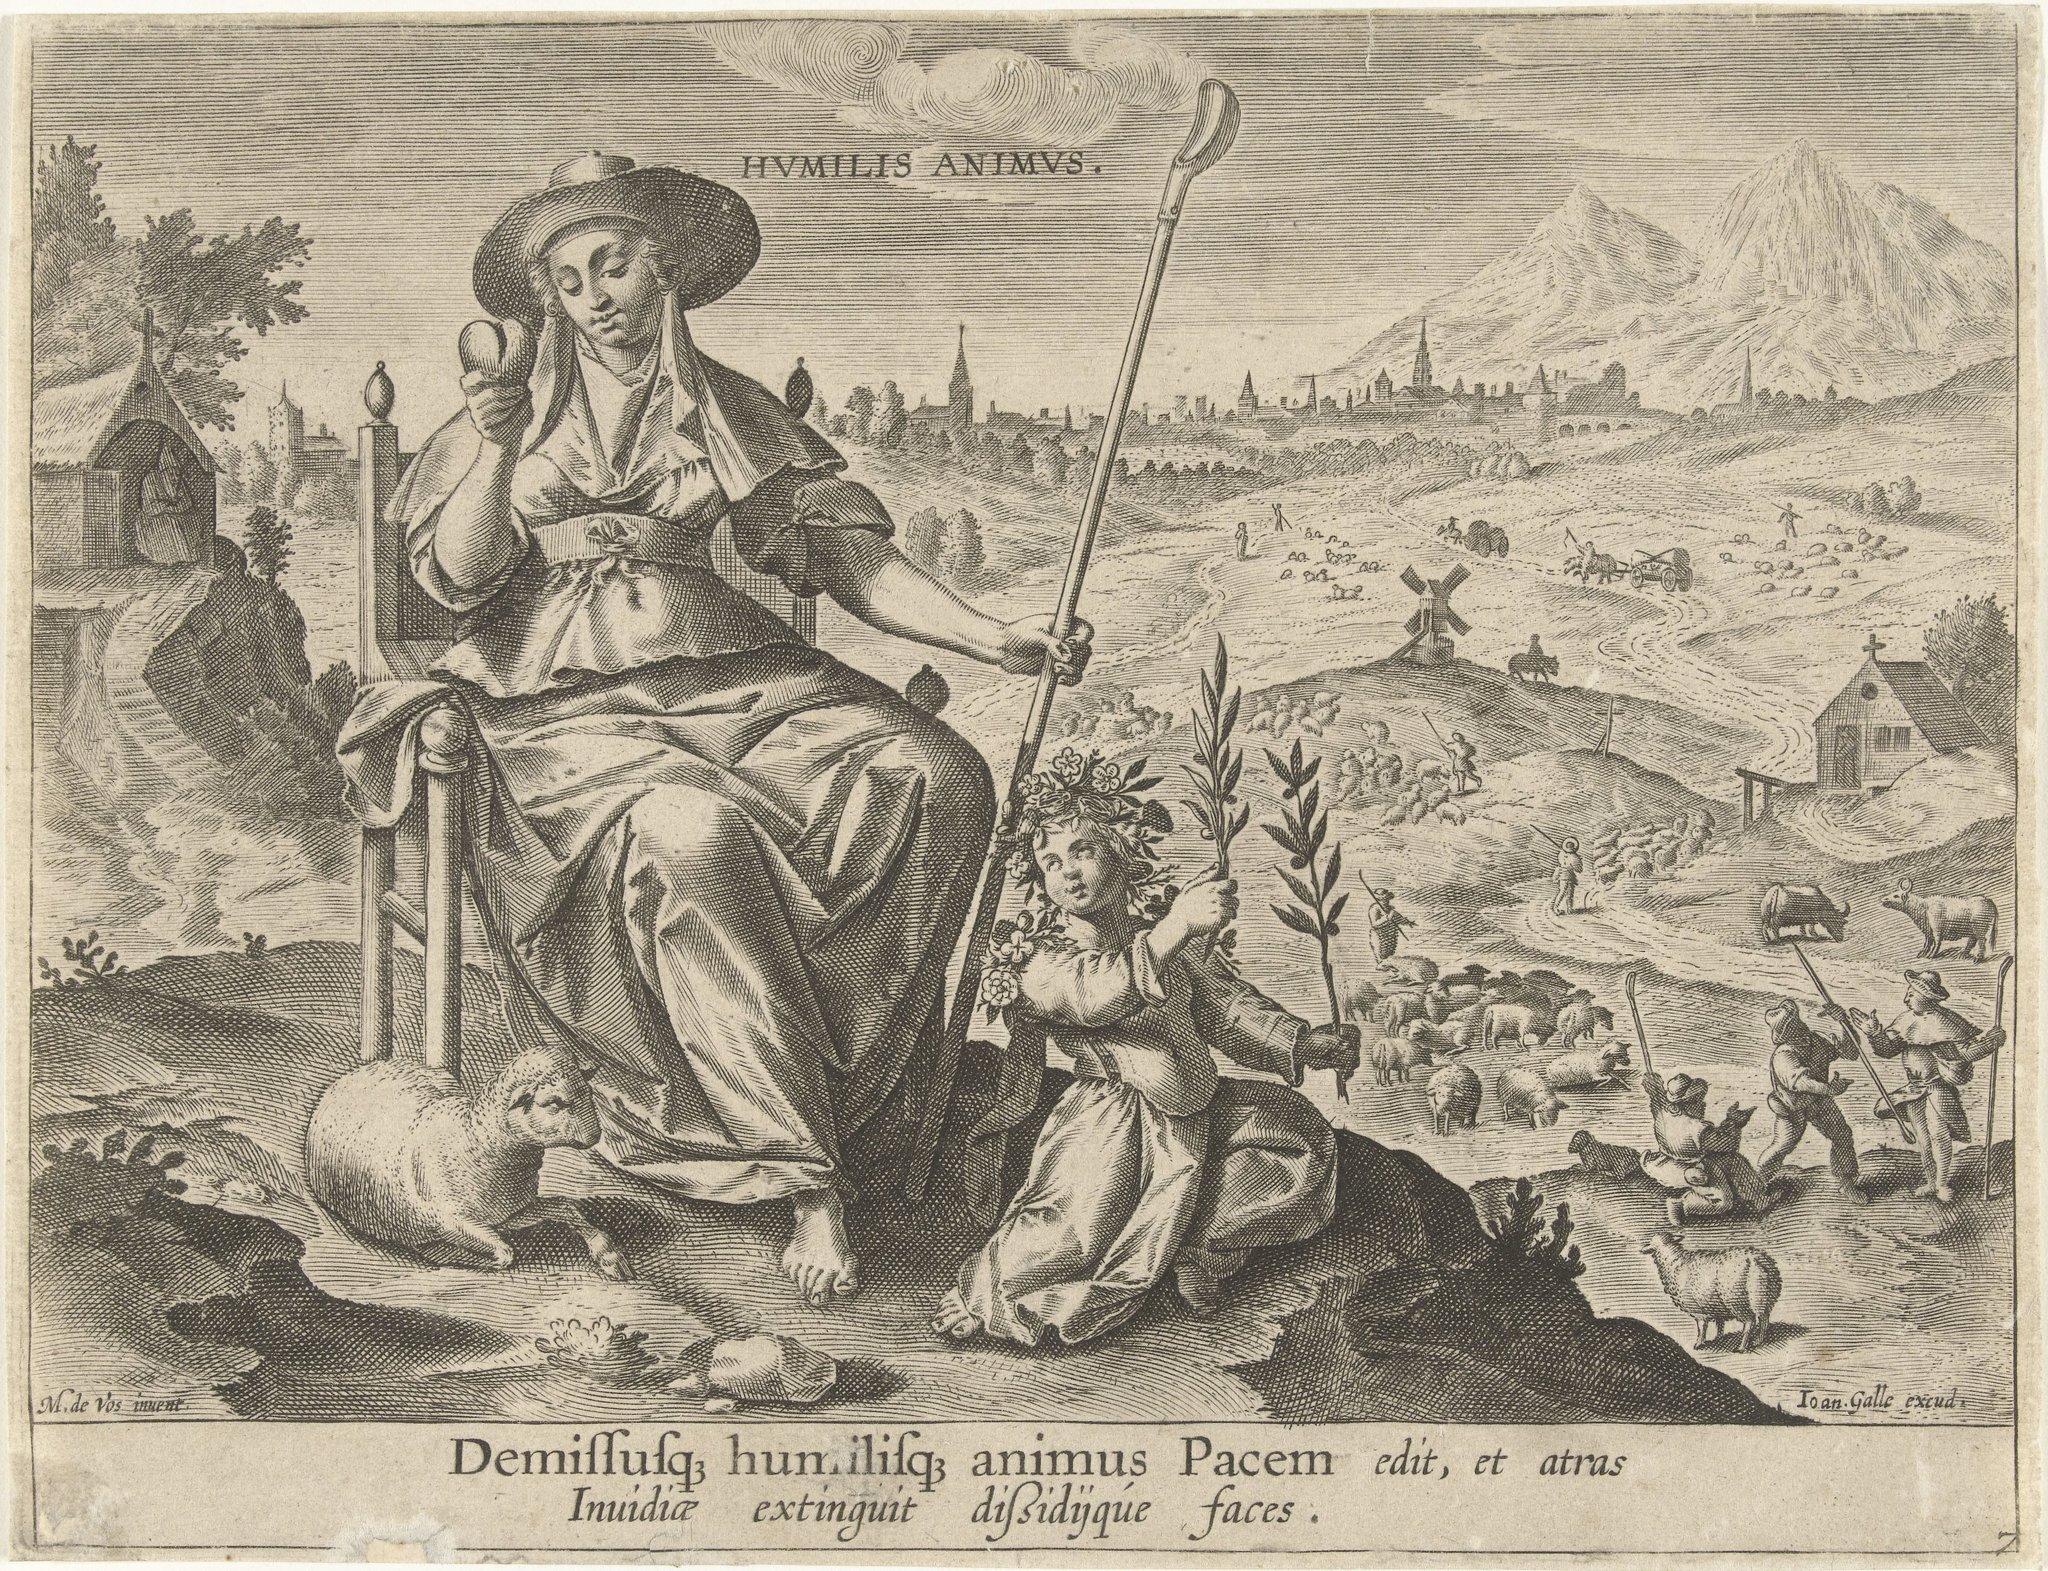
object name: print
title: Circvlvs Vicissitvdinis Rervm Hvmanarvm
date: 1610-1676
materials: paper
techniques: engraving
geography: antwerp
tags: symbols, allegories of peace, 'pax'; 'pace' (ripa), vicissitudes of life, pastorals, arcadian scenes, humility; 'humiltà' (ripa)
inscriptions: collector's mark: Lugt 2228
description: De personificatie van Nederigheid (Humilis Animus) zit op een stoel, een herdersstaf en een gekliefd hart in haar handen. Aan haar voeten ligt een schaap en zit Vrede (Pax): een meisje met een olijftak in de handen. Op de achtergrond het boerenleven en herders op het veld. De prent heeft een Latijns onderschrift en is deel van een serie over de kringloop van het menselijk handelen.